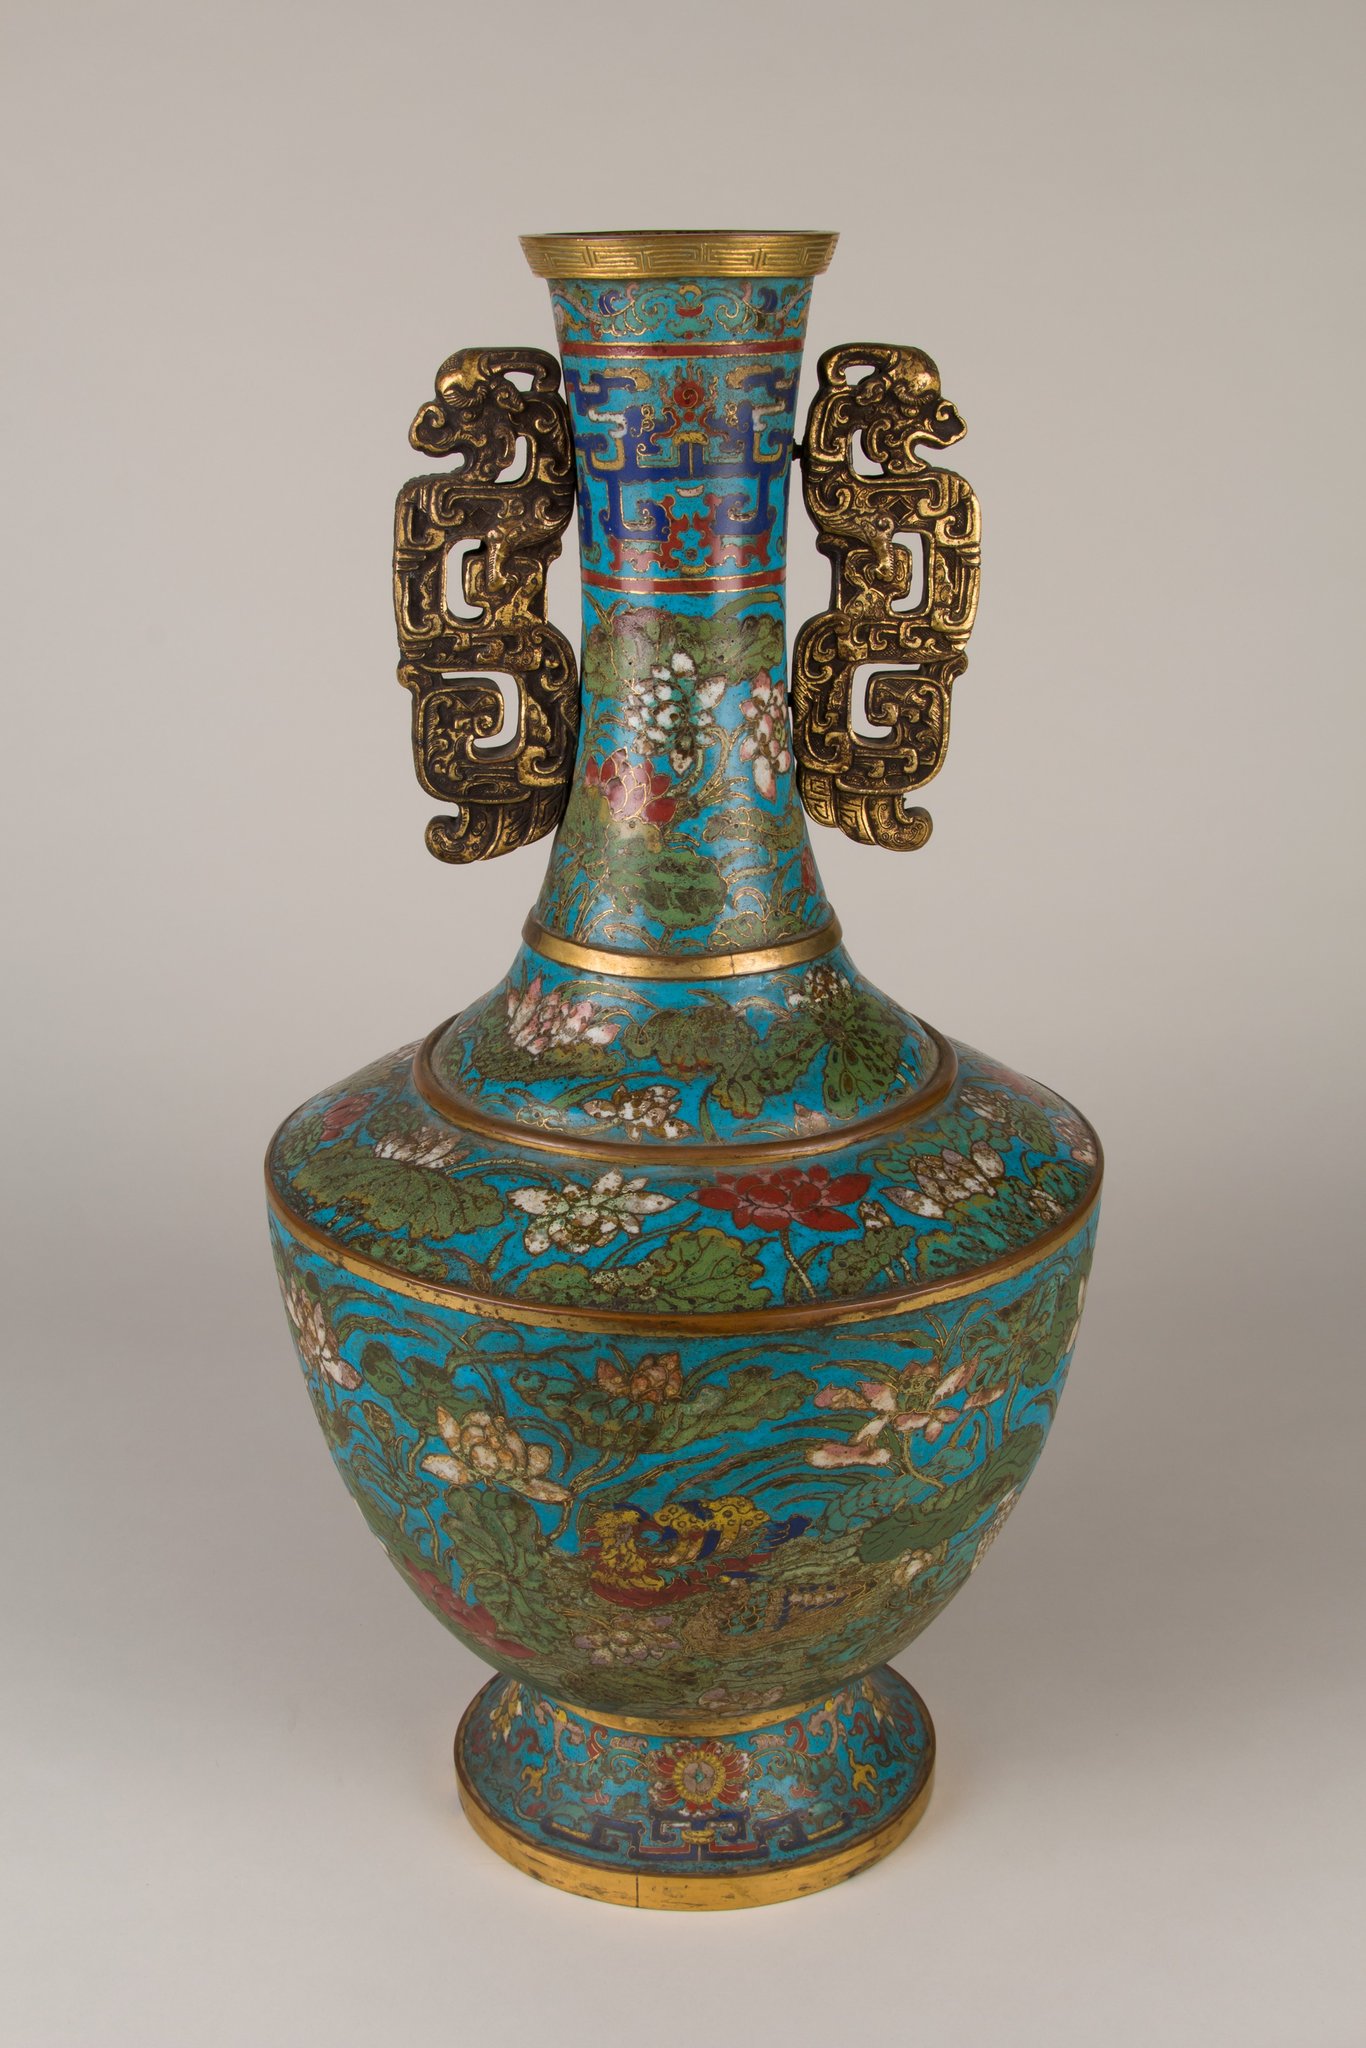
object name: vase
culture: chinese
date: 1662-1722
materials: enamel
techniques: enamel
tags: flowers,leaves